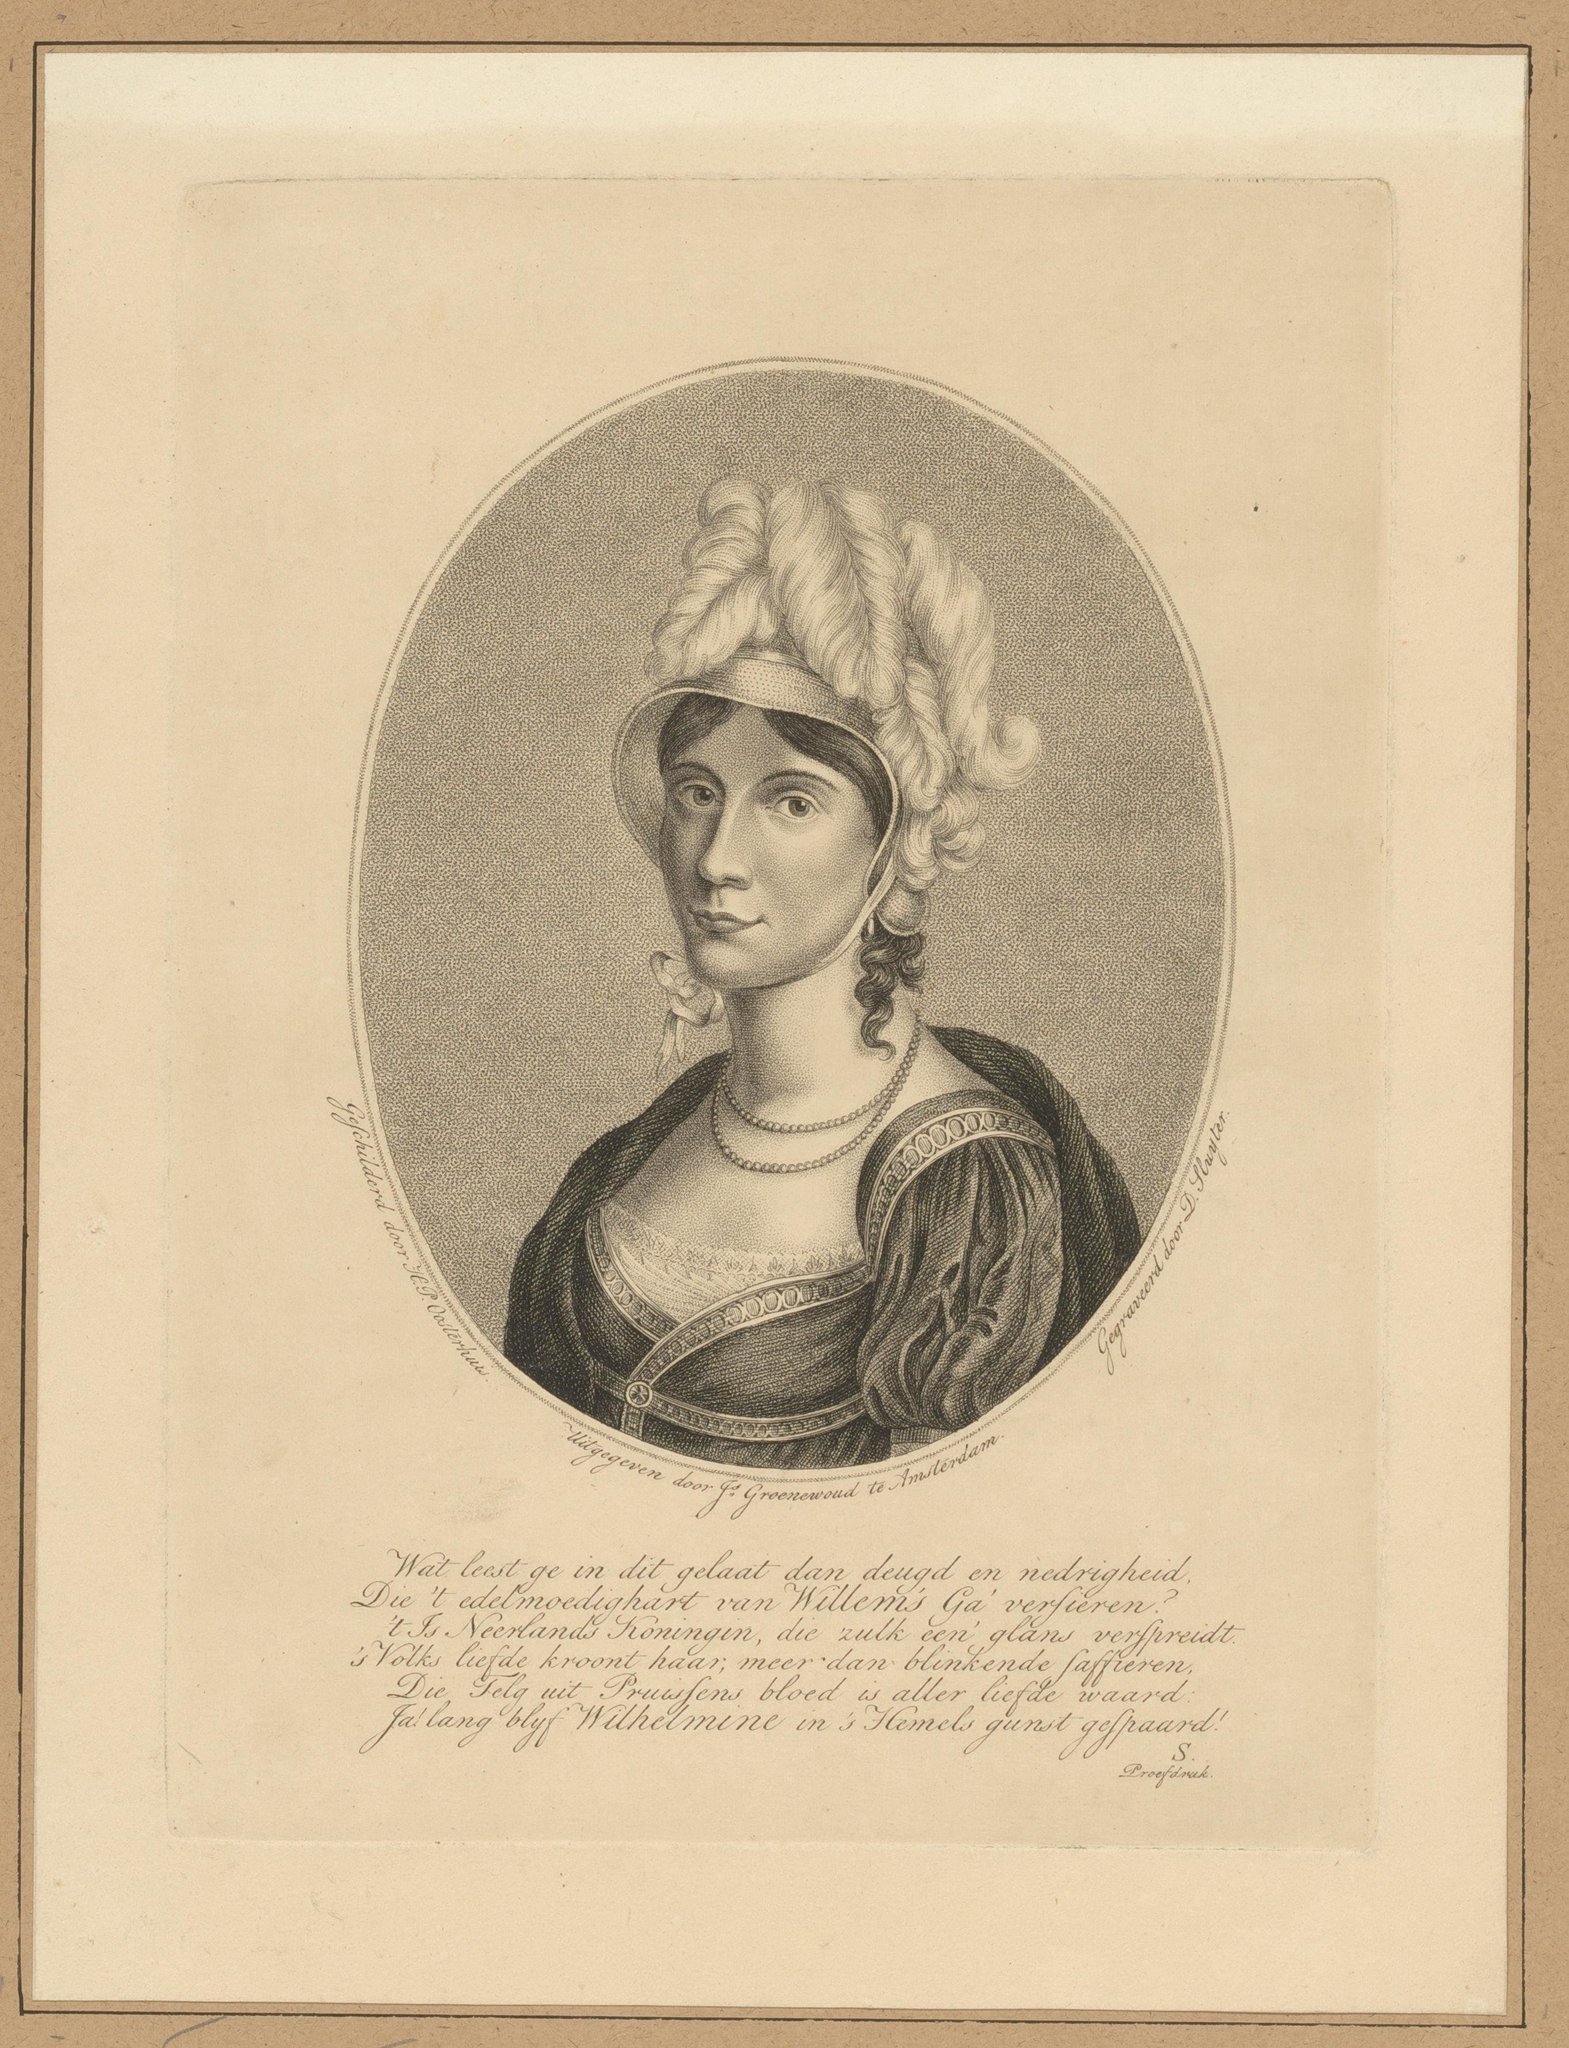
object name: print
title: Portret van Wilhelmina van Pruisen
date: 1815-1819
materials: paper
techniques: engraving, etching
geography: amsterdam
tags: berlin, the hague, wilhelmina frederica louisa (koningin der nederlanden), historical persons, king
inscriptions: stamp, collector's mark: Lugt 1641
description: Portret van Wilhelmina in een ovaal. In de ondermarge zes regels Nederlandse tekst. Onderwerpsrubrieken binnen de Atlas Zeden en Gewoonten: Portretten, Portretten van Vorsten uit het huis van Oranje, Regeerende Vorsten, Koningen uit het huis van Oranje.